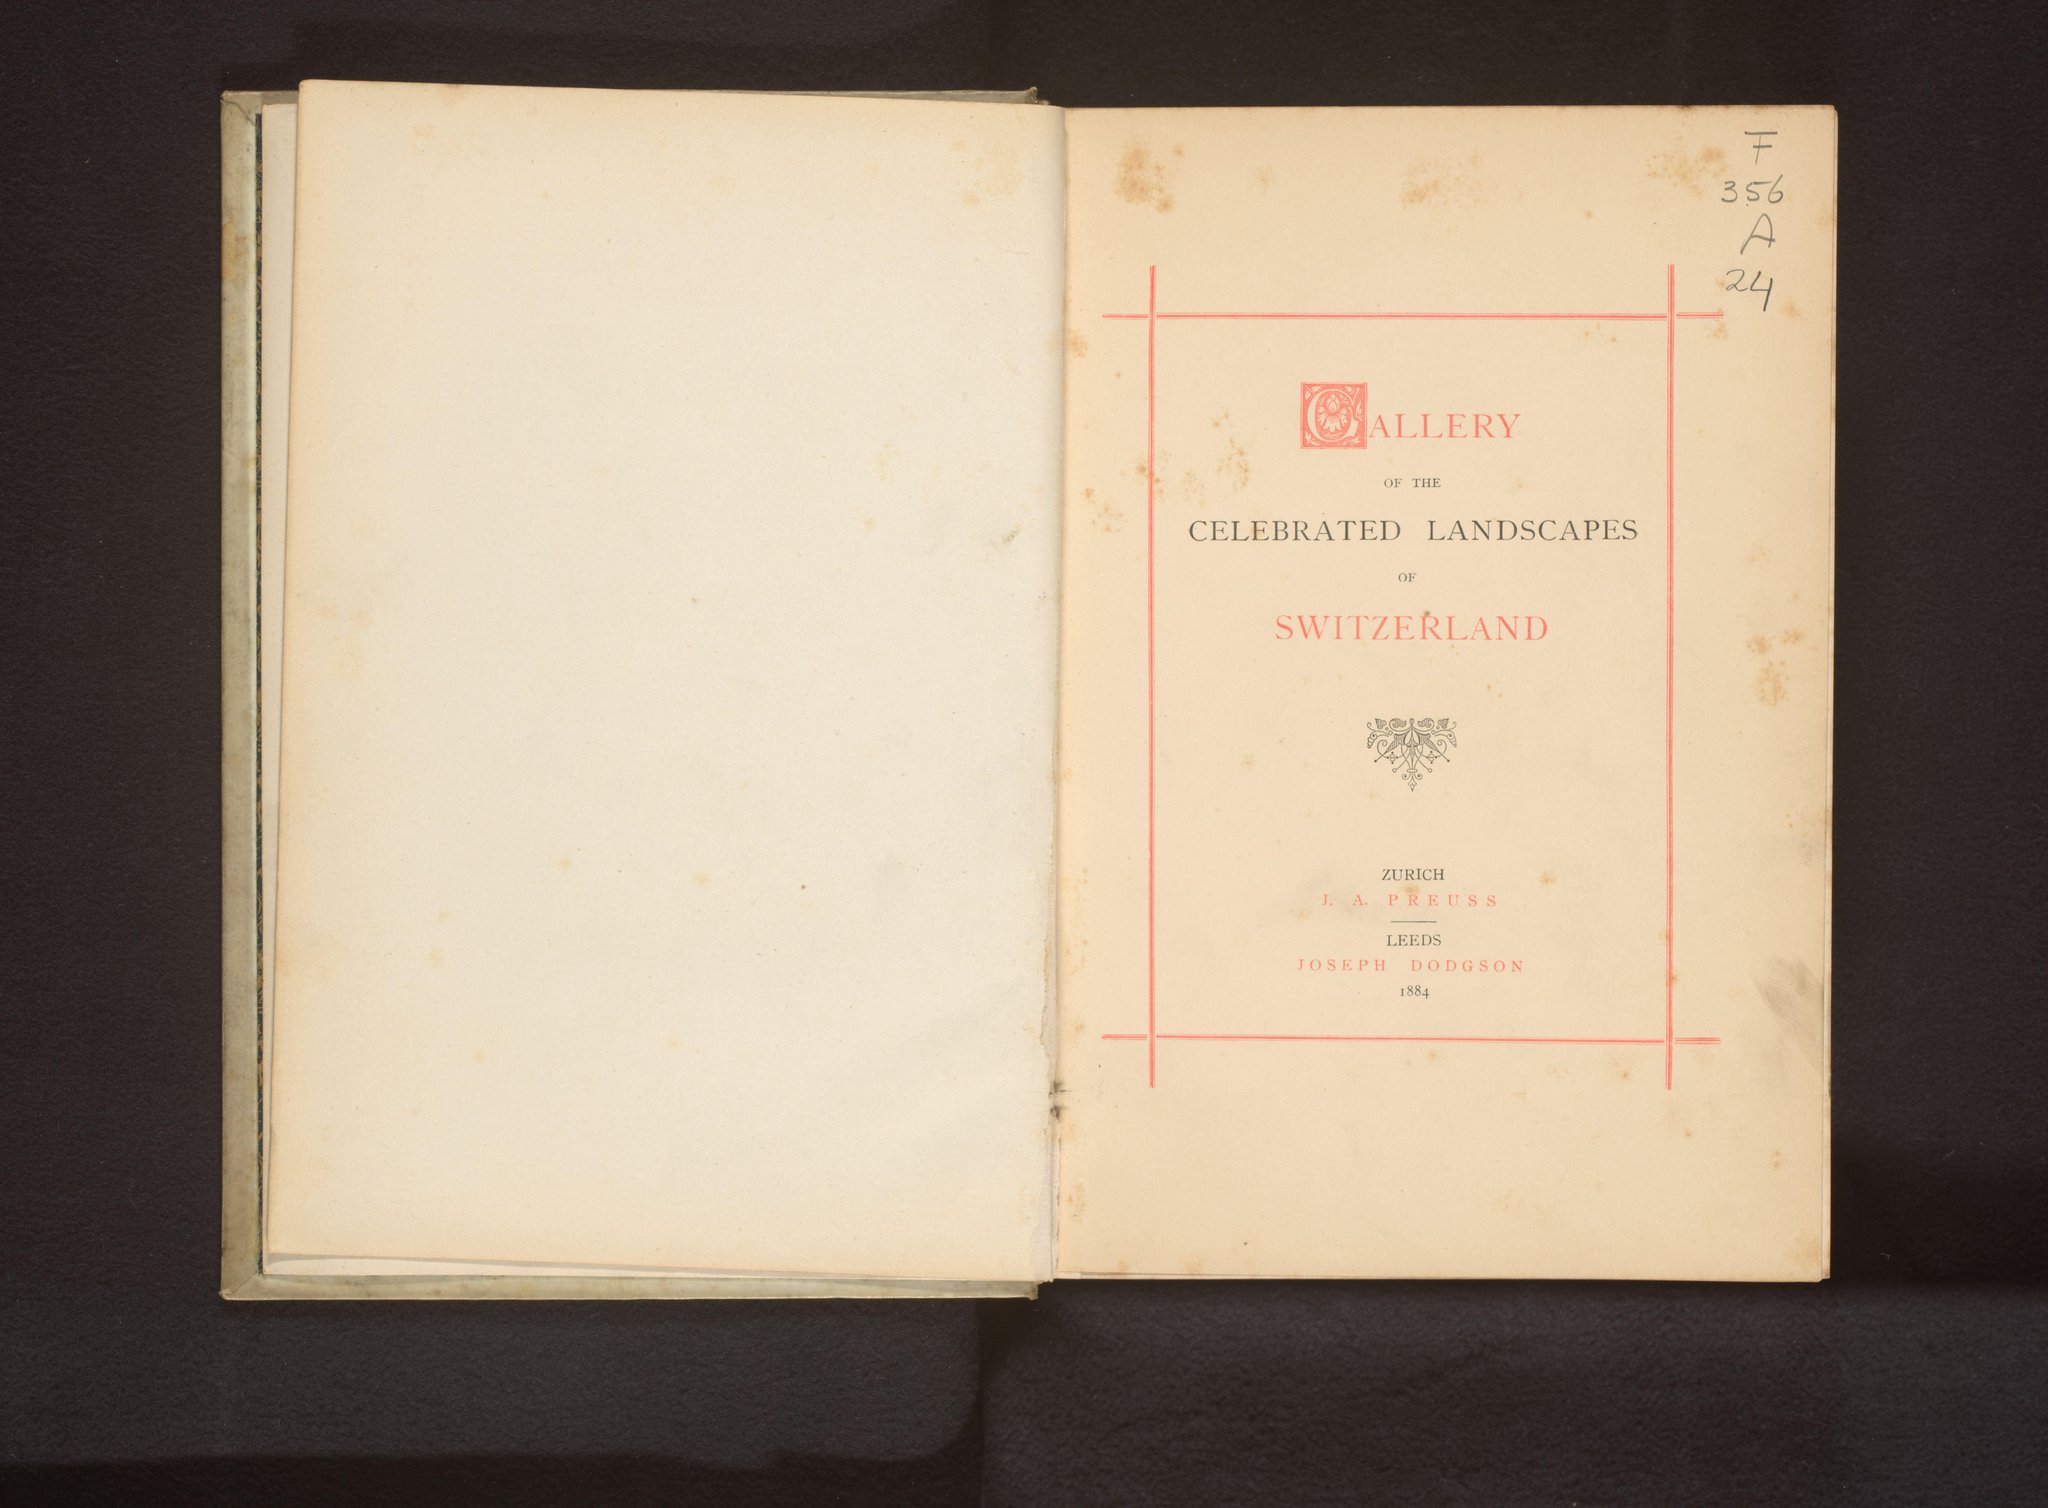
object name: book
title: Gallery of the celebrated landscapes of Switzerland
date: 1884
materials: cardboard, paper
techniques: photograph, decorated paper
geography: leeds